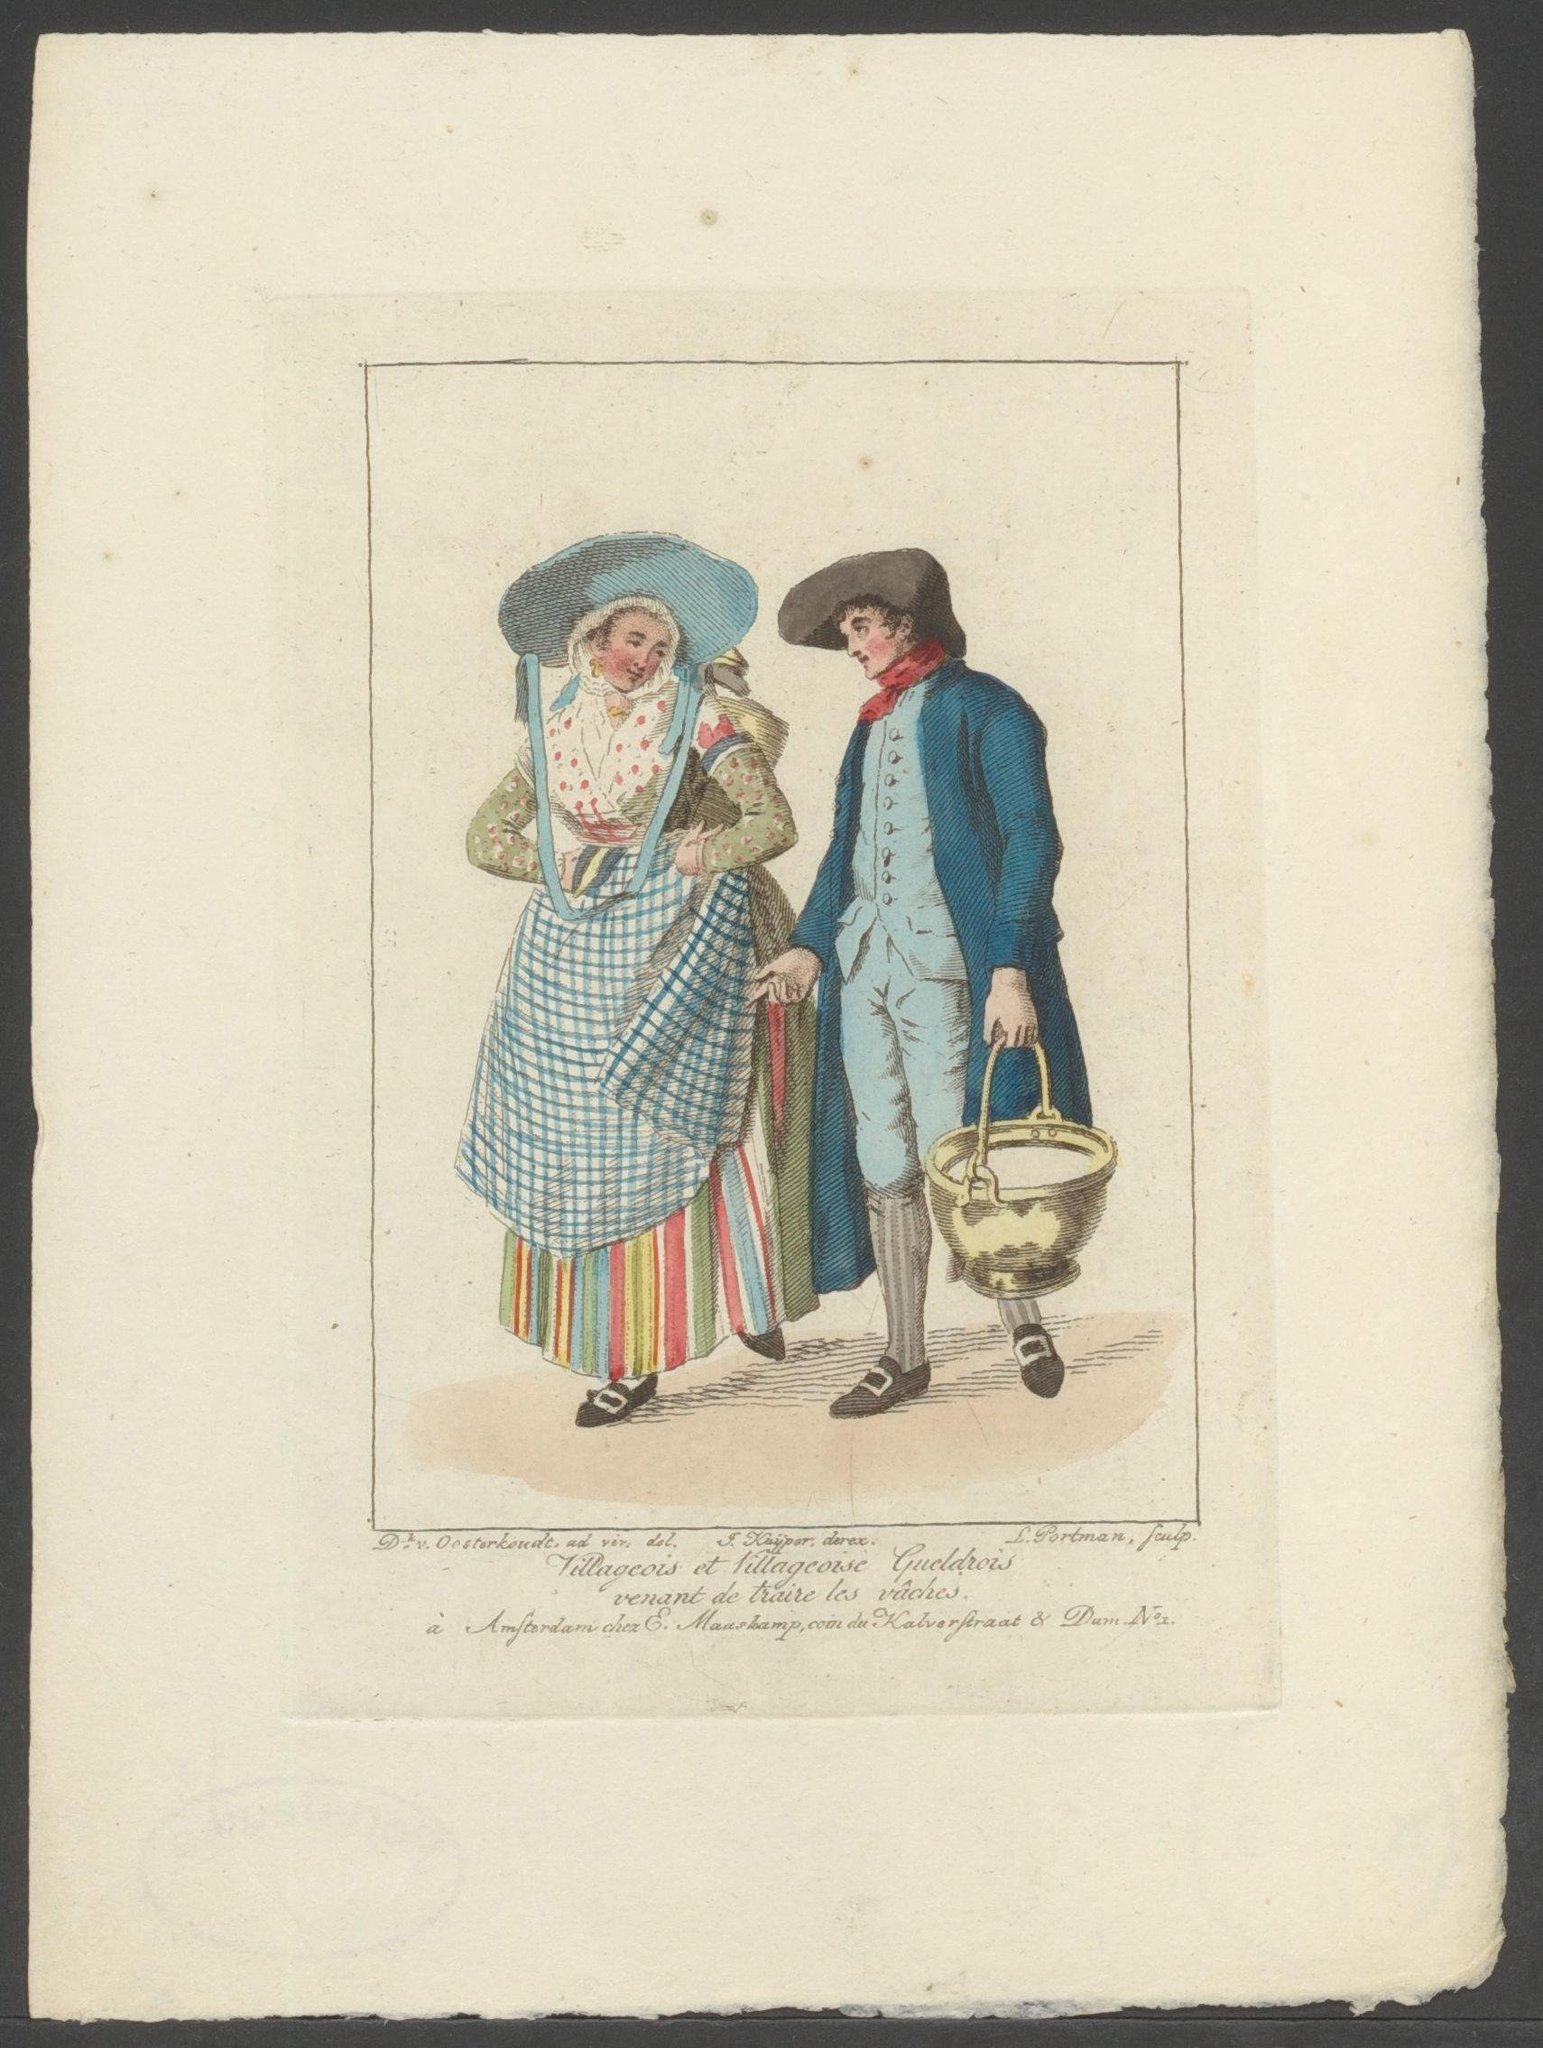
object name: print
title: Un Paysan et une Paysannne de Gueldre, venant de traire les vaches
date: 1813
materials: paper, watercolor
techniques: etching, hand coloring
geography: amsterdam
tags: farmers, farmers - aa - female farmer, farmer's wife, clothes, costume (+ women's clothes), clothes, costume (+ men's clothes), folk costume, regional costume, transportation of milk, gelderland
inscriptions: collector's mark: Lugt 1641, collector's mark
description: Een Gelders boerenpaar dat zojuist de koeien heeft gemolken. De boer draagt een vat met melk. Bij de prent zit ook een blad met de Franse titel. Onderdeel van de verkleinde kopieën uit 1812 naar de platen van Nederlandse klederdrachten uit de jaren 1803-1807. Onderwerpsrubrieken binnen de Atlas Zeden en Gewoonten: De Kleeding, Volkskleederdracht.